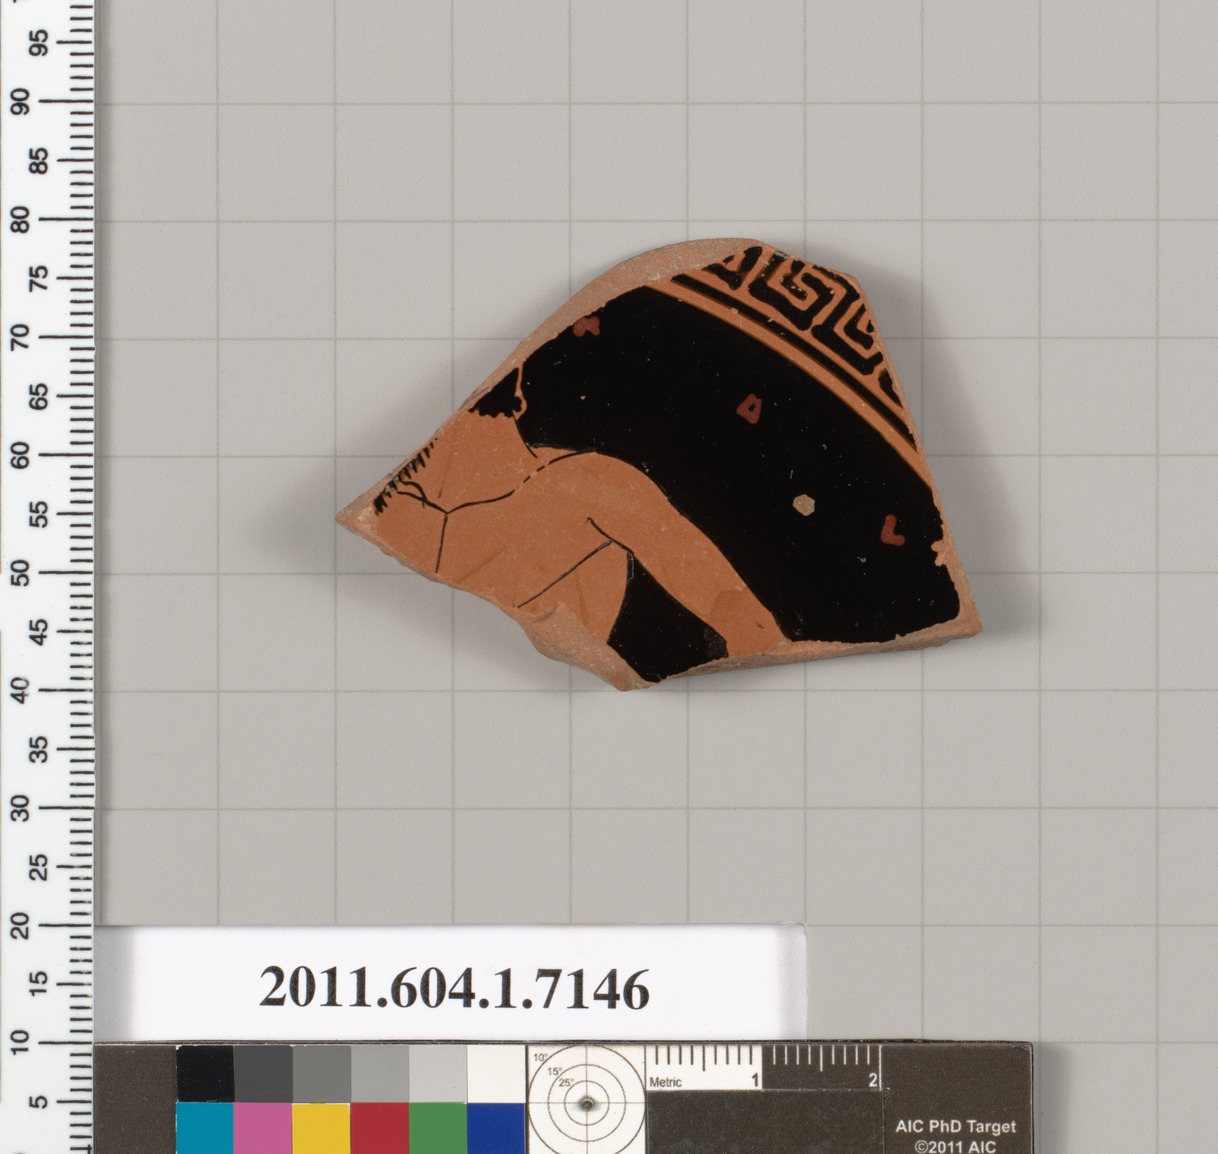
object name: kylix fragment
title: Terracotta fragment of a kylix (drinking cup)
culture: greek, attic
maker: makron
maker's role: artist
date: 500-480 BCE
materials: terracotta